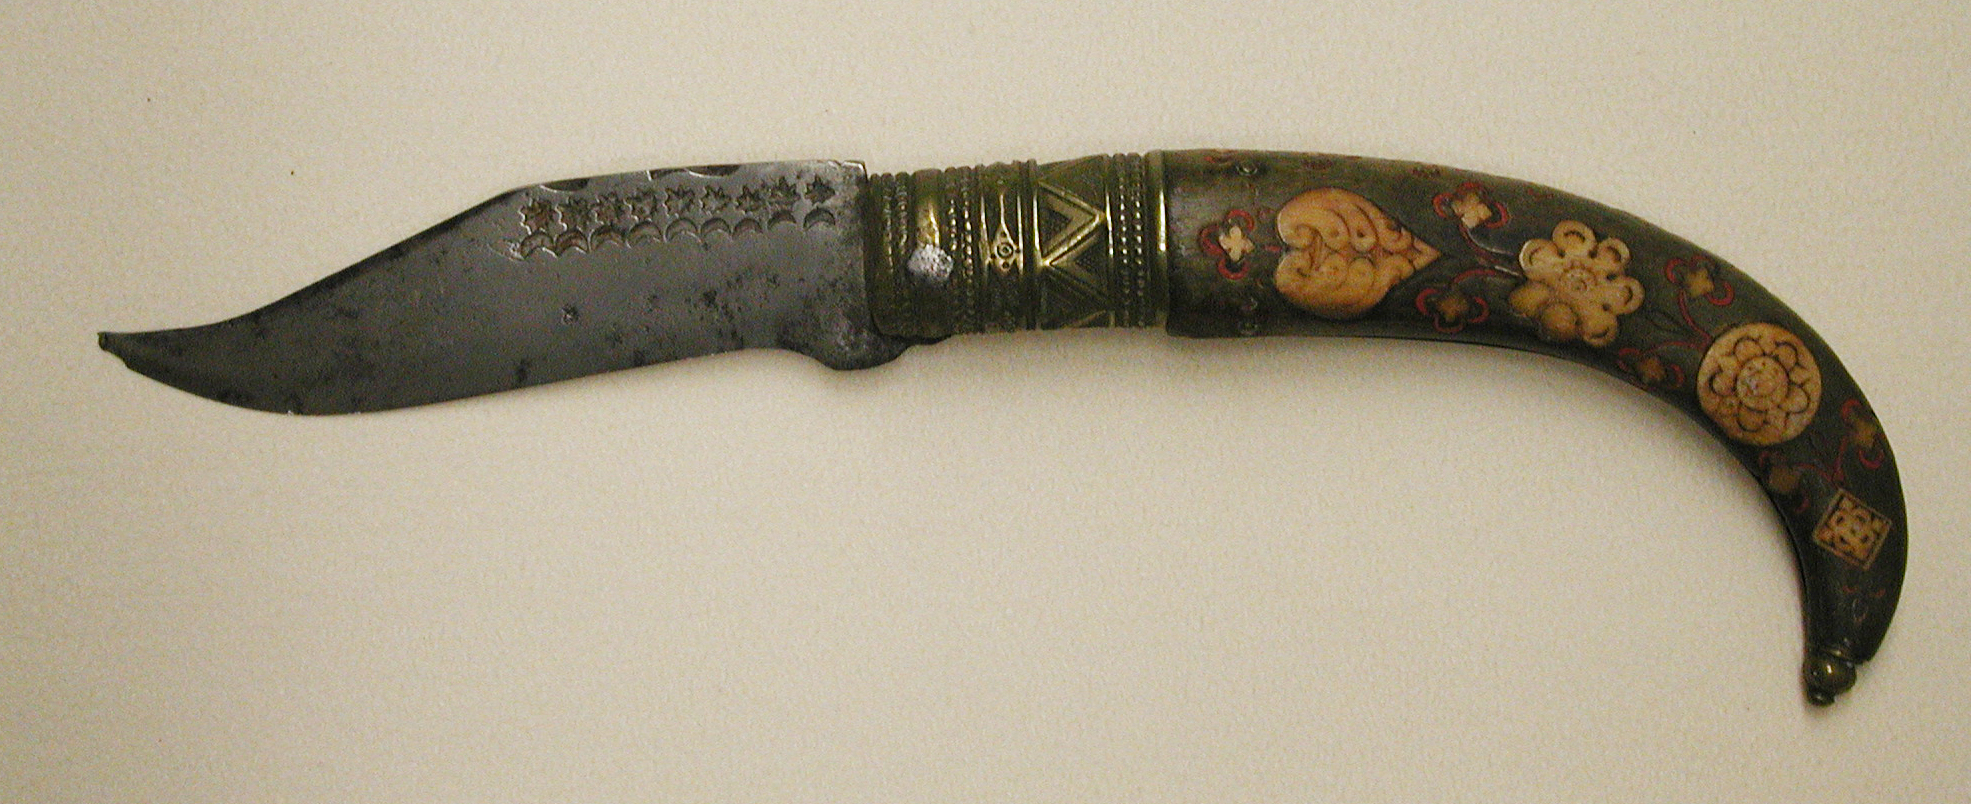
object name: knife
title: Witch Knife (Drudenmesser)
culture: austrian or italian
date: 1801-1900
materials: bone, brass, horn, pigment, steel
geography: italy